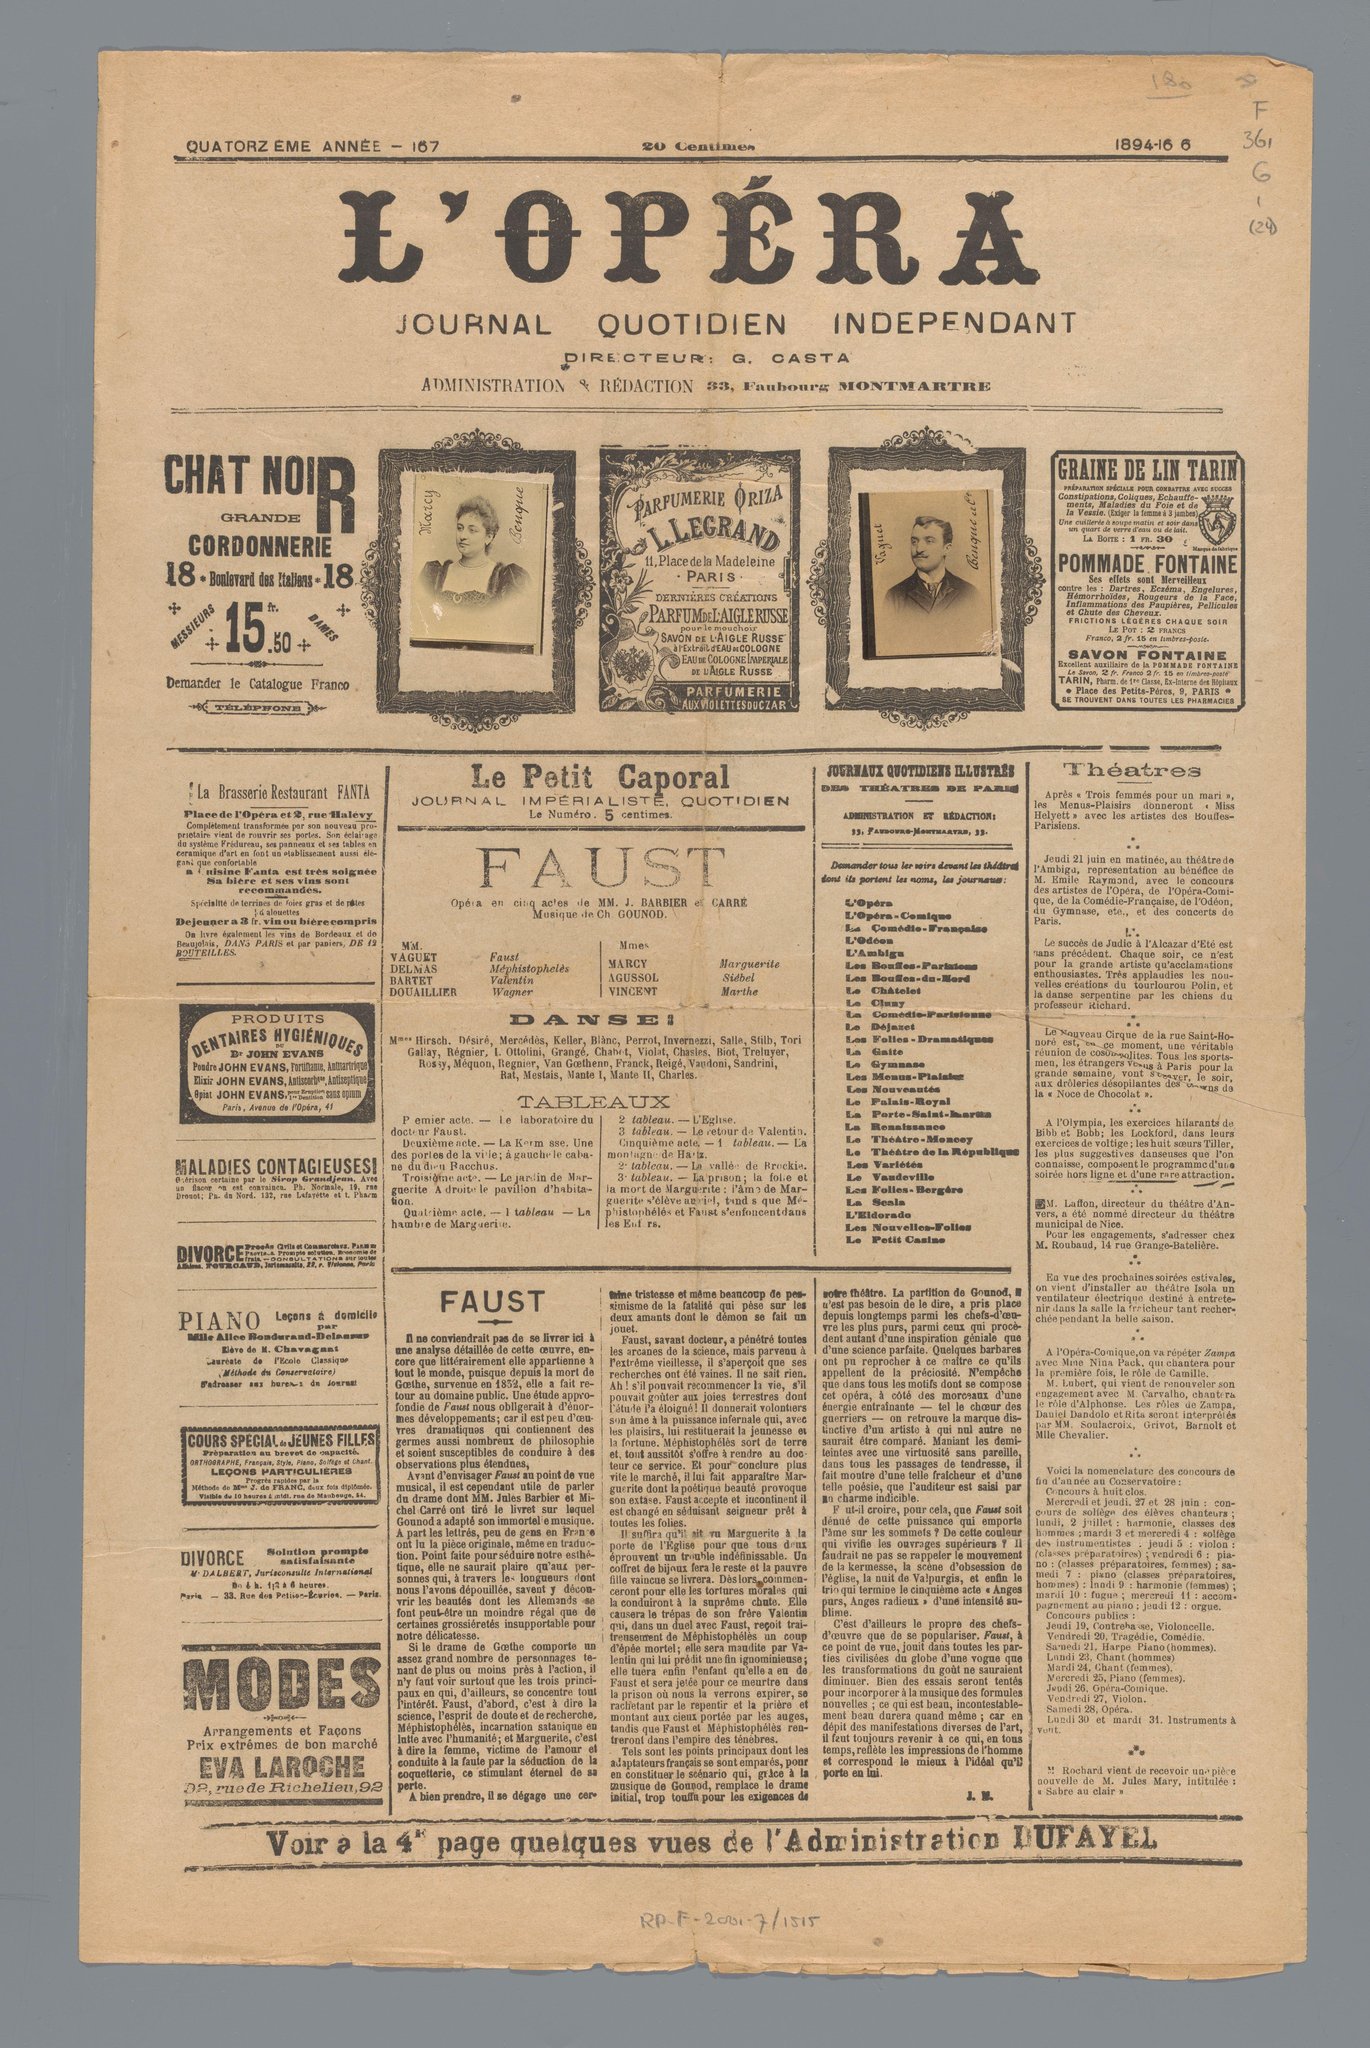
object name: photomechanical print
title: Marcy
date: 1889-1894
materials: paper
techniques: photograph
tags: historical persons - bb - woman, portrait of opera-singer